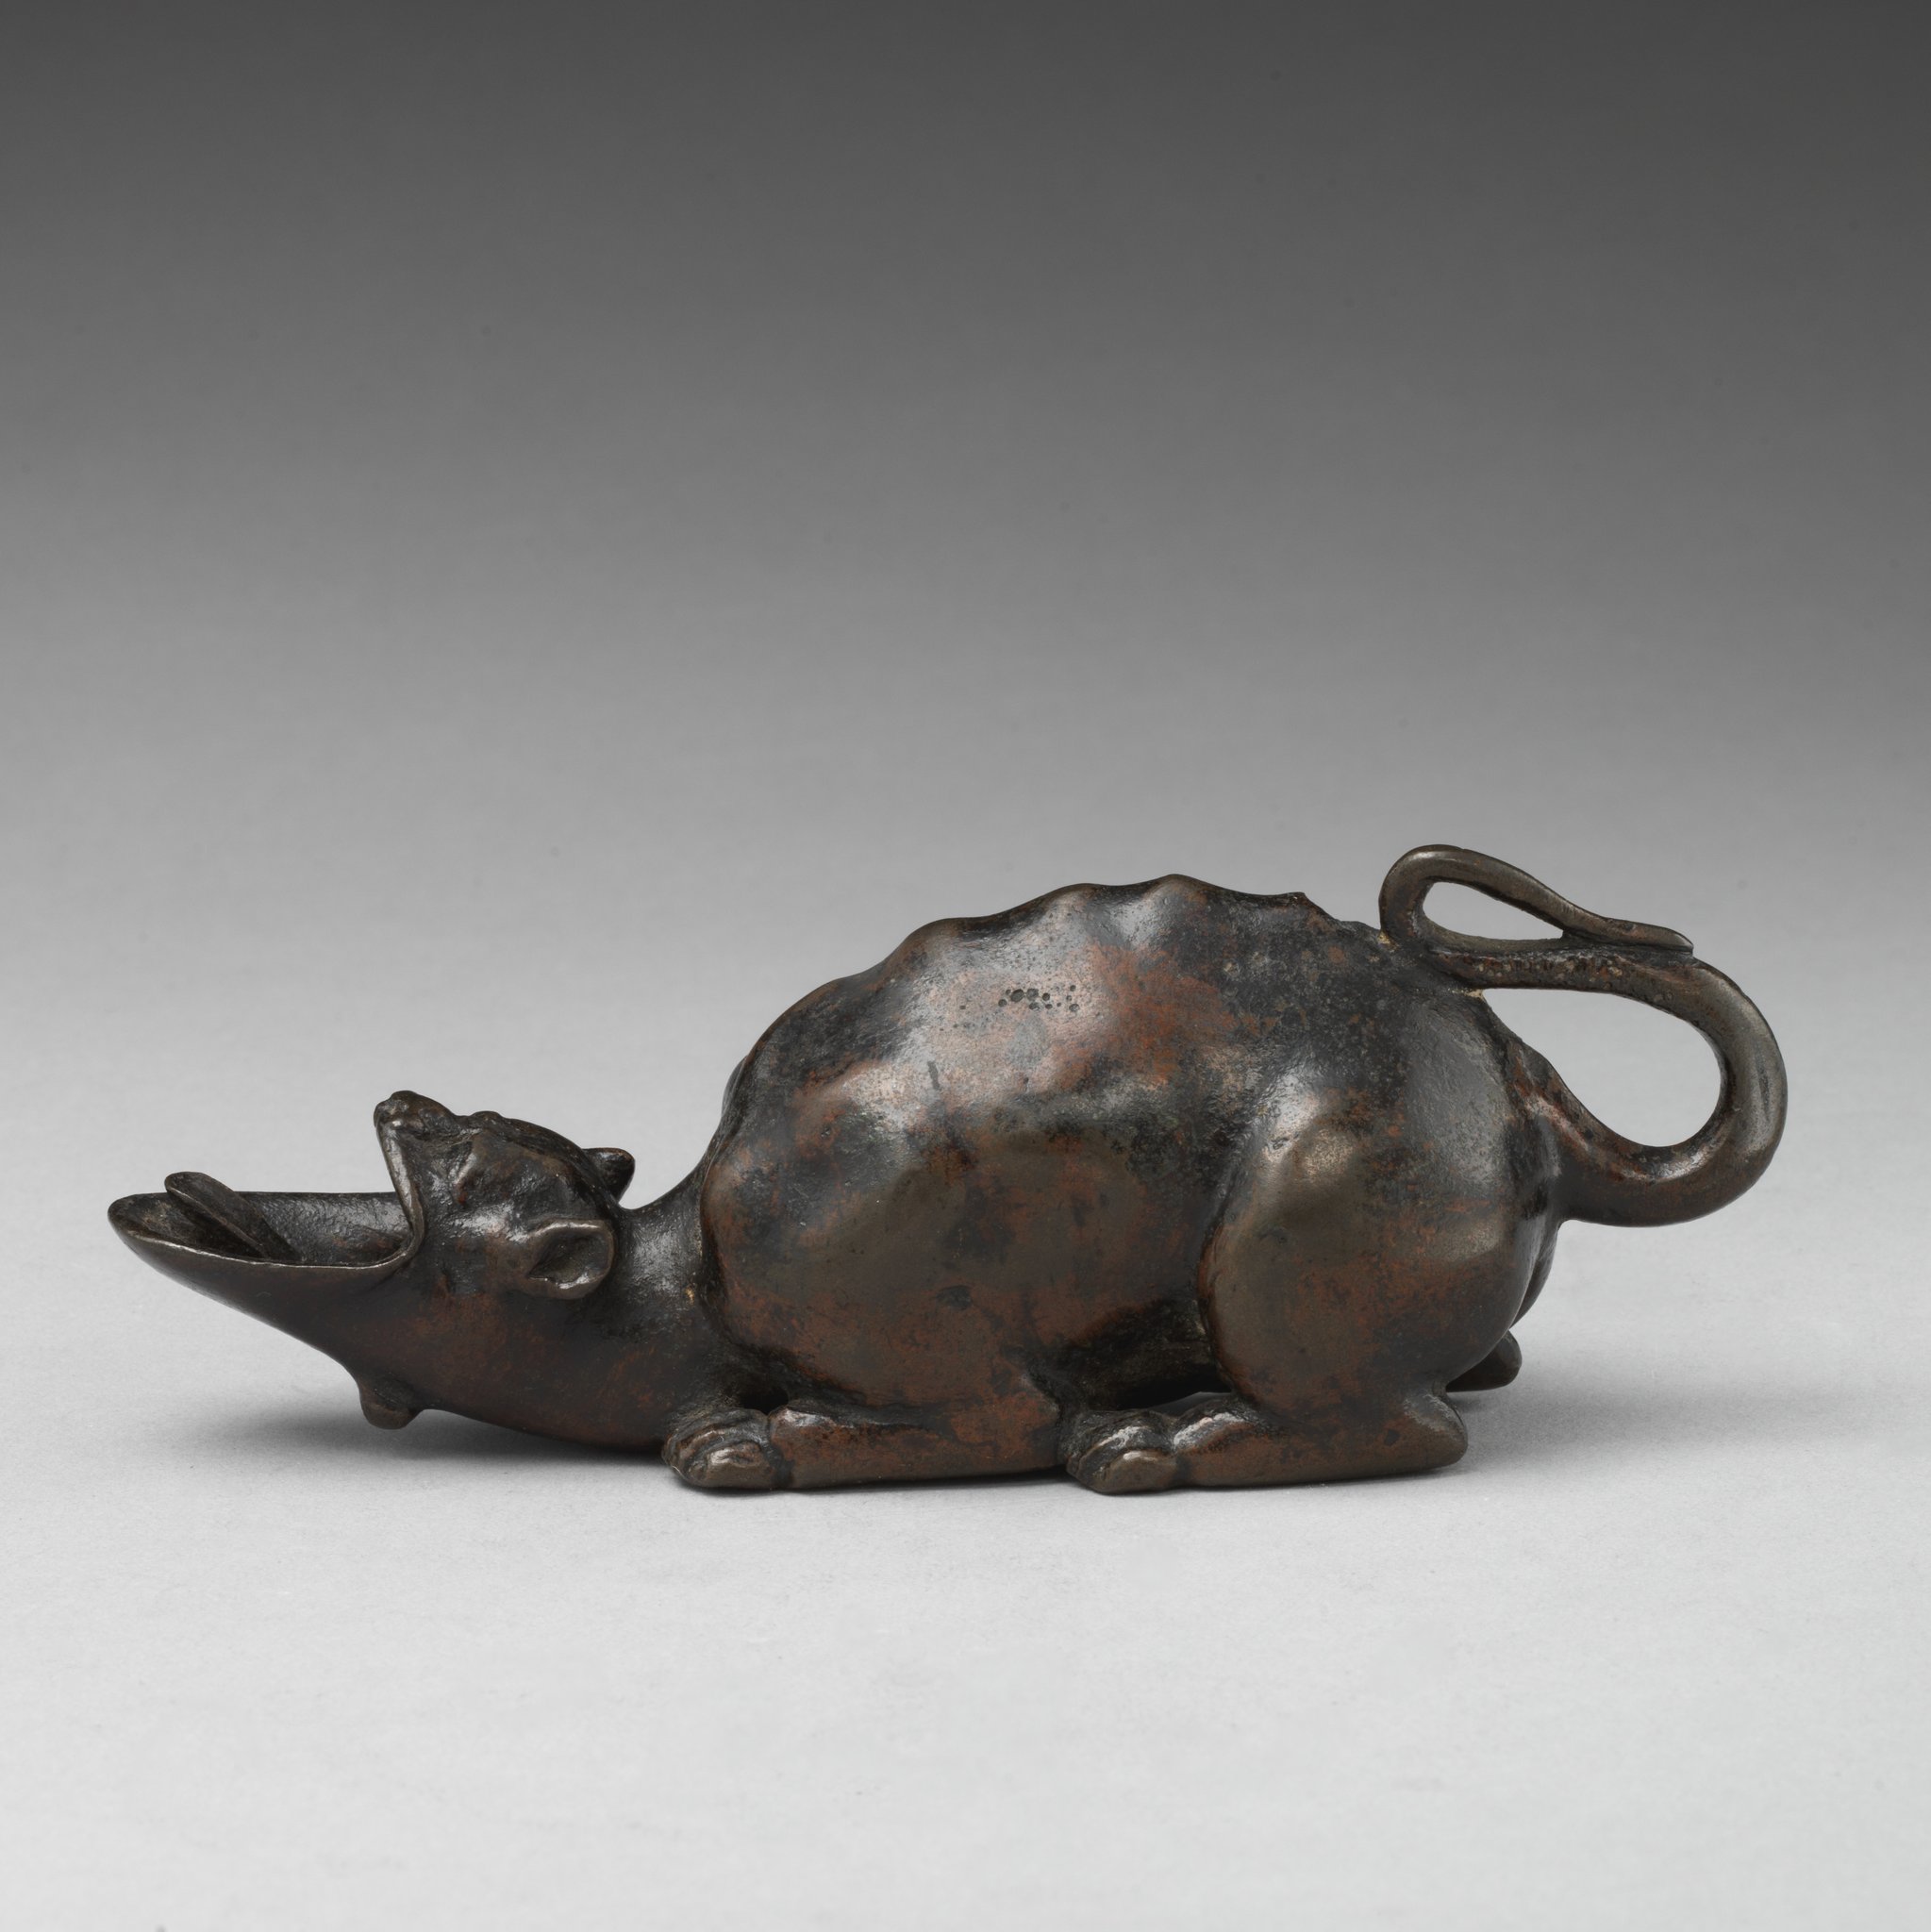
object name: oil lamp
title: Oil lamp in the form of a grotesque animal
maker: andrea briosco, called riccio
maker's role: maker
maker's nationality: italian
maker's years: 1470-1532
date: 1601-1700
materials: bronze